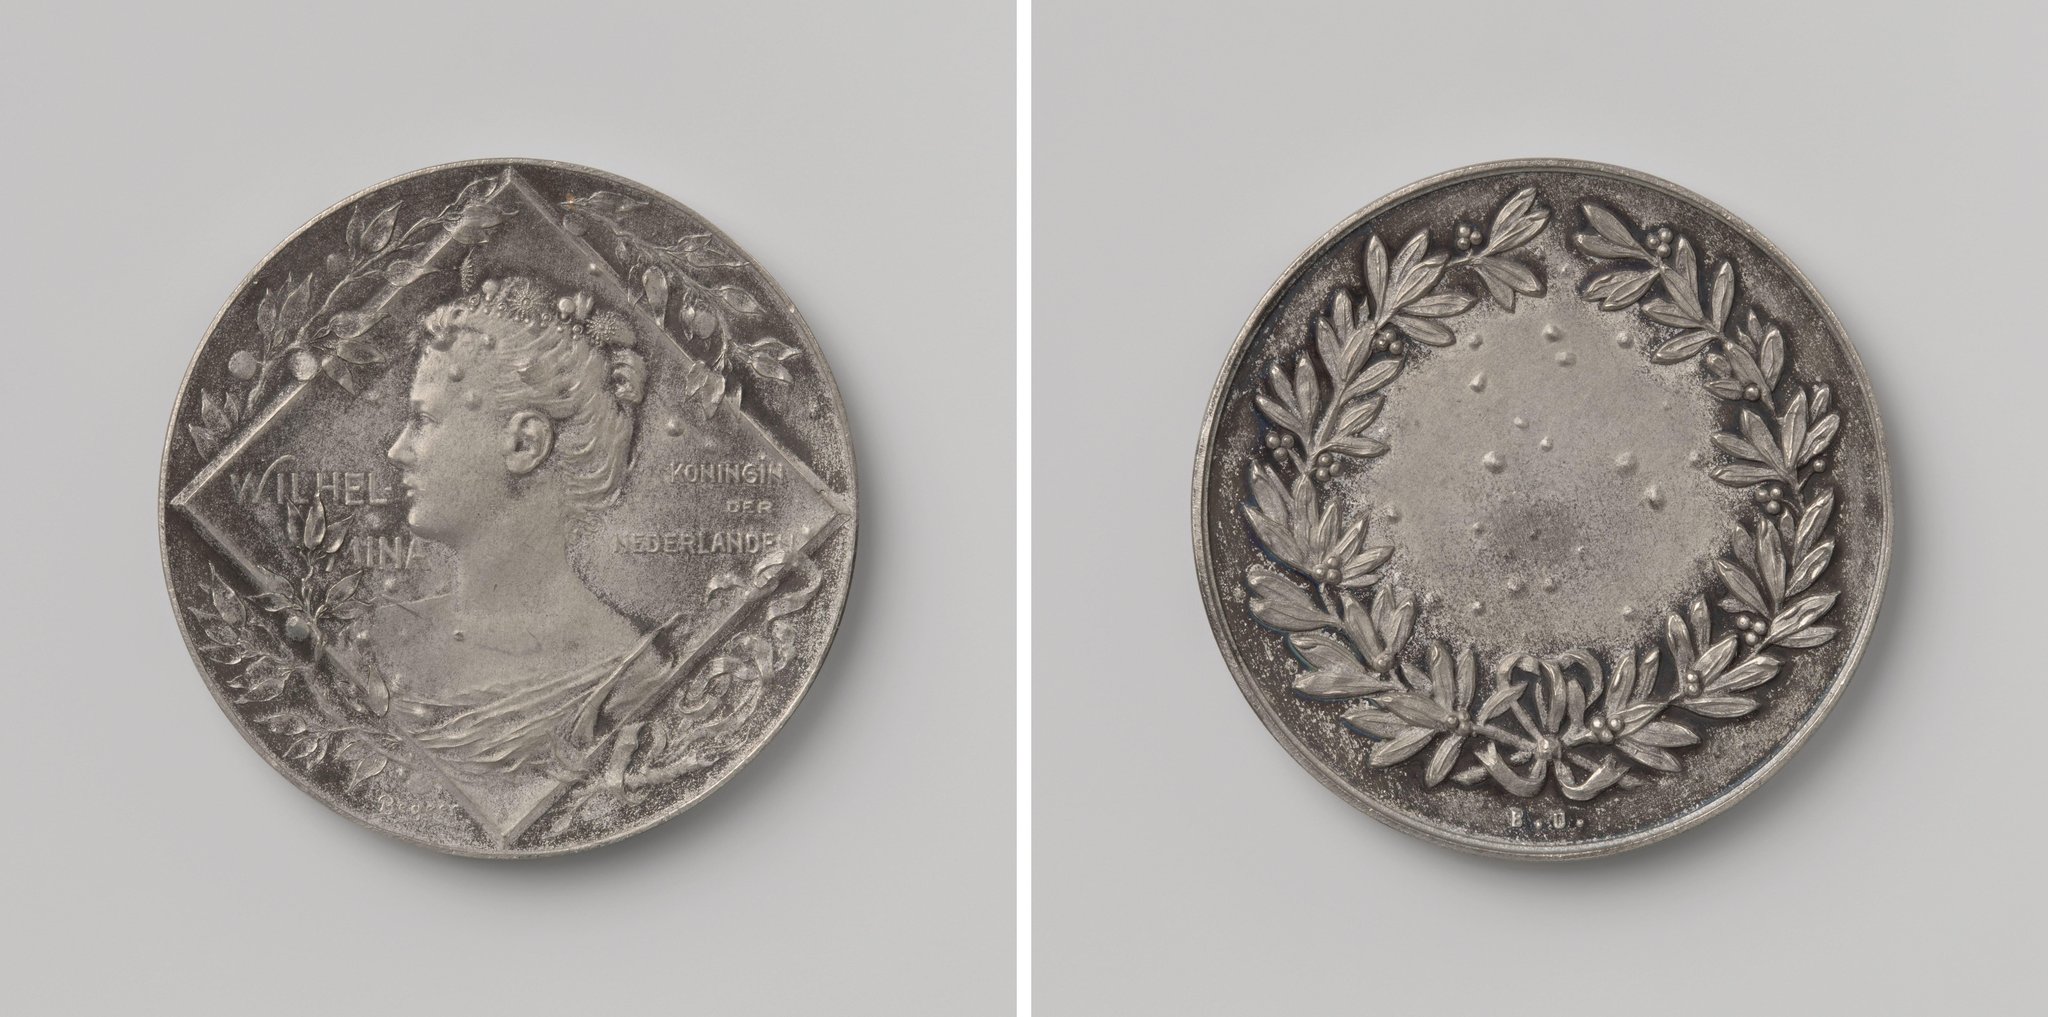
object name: honorary medal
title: Inhuldiging van Wilhelmina als koningin der Nederlanden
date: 1898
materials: silver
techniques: striking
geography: utrecht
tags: the hague, print maker, wilhelmina of the netherlands, netherlands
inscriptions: inscription: ‘WILHELMINA KONINGIN DER NEDERLANDEN’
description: Zilveren penning. Voorzijde: borststuk vrouw met diadeem tussen opschriften in ruit: daar omheen oranjetakken onder samengebonden met linten. Keerzijde: blanco veld binnen lauwerkrans.